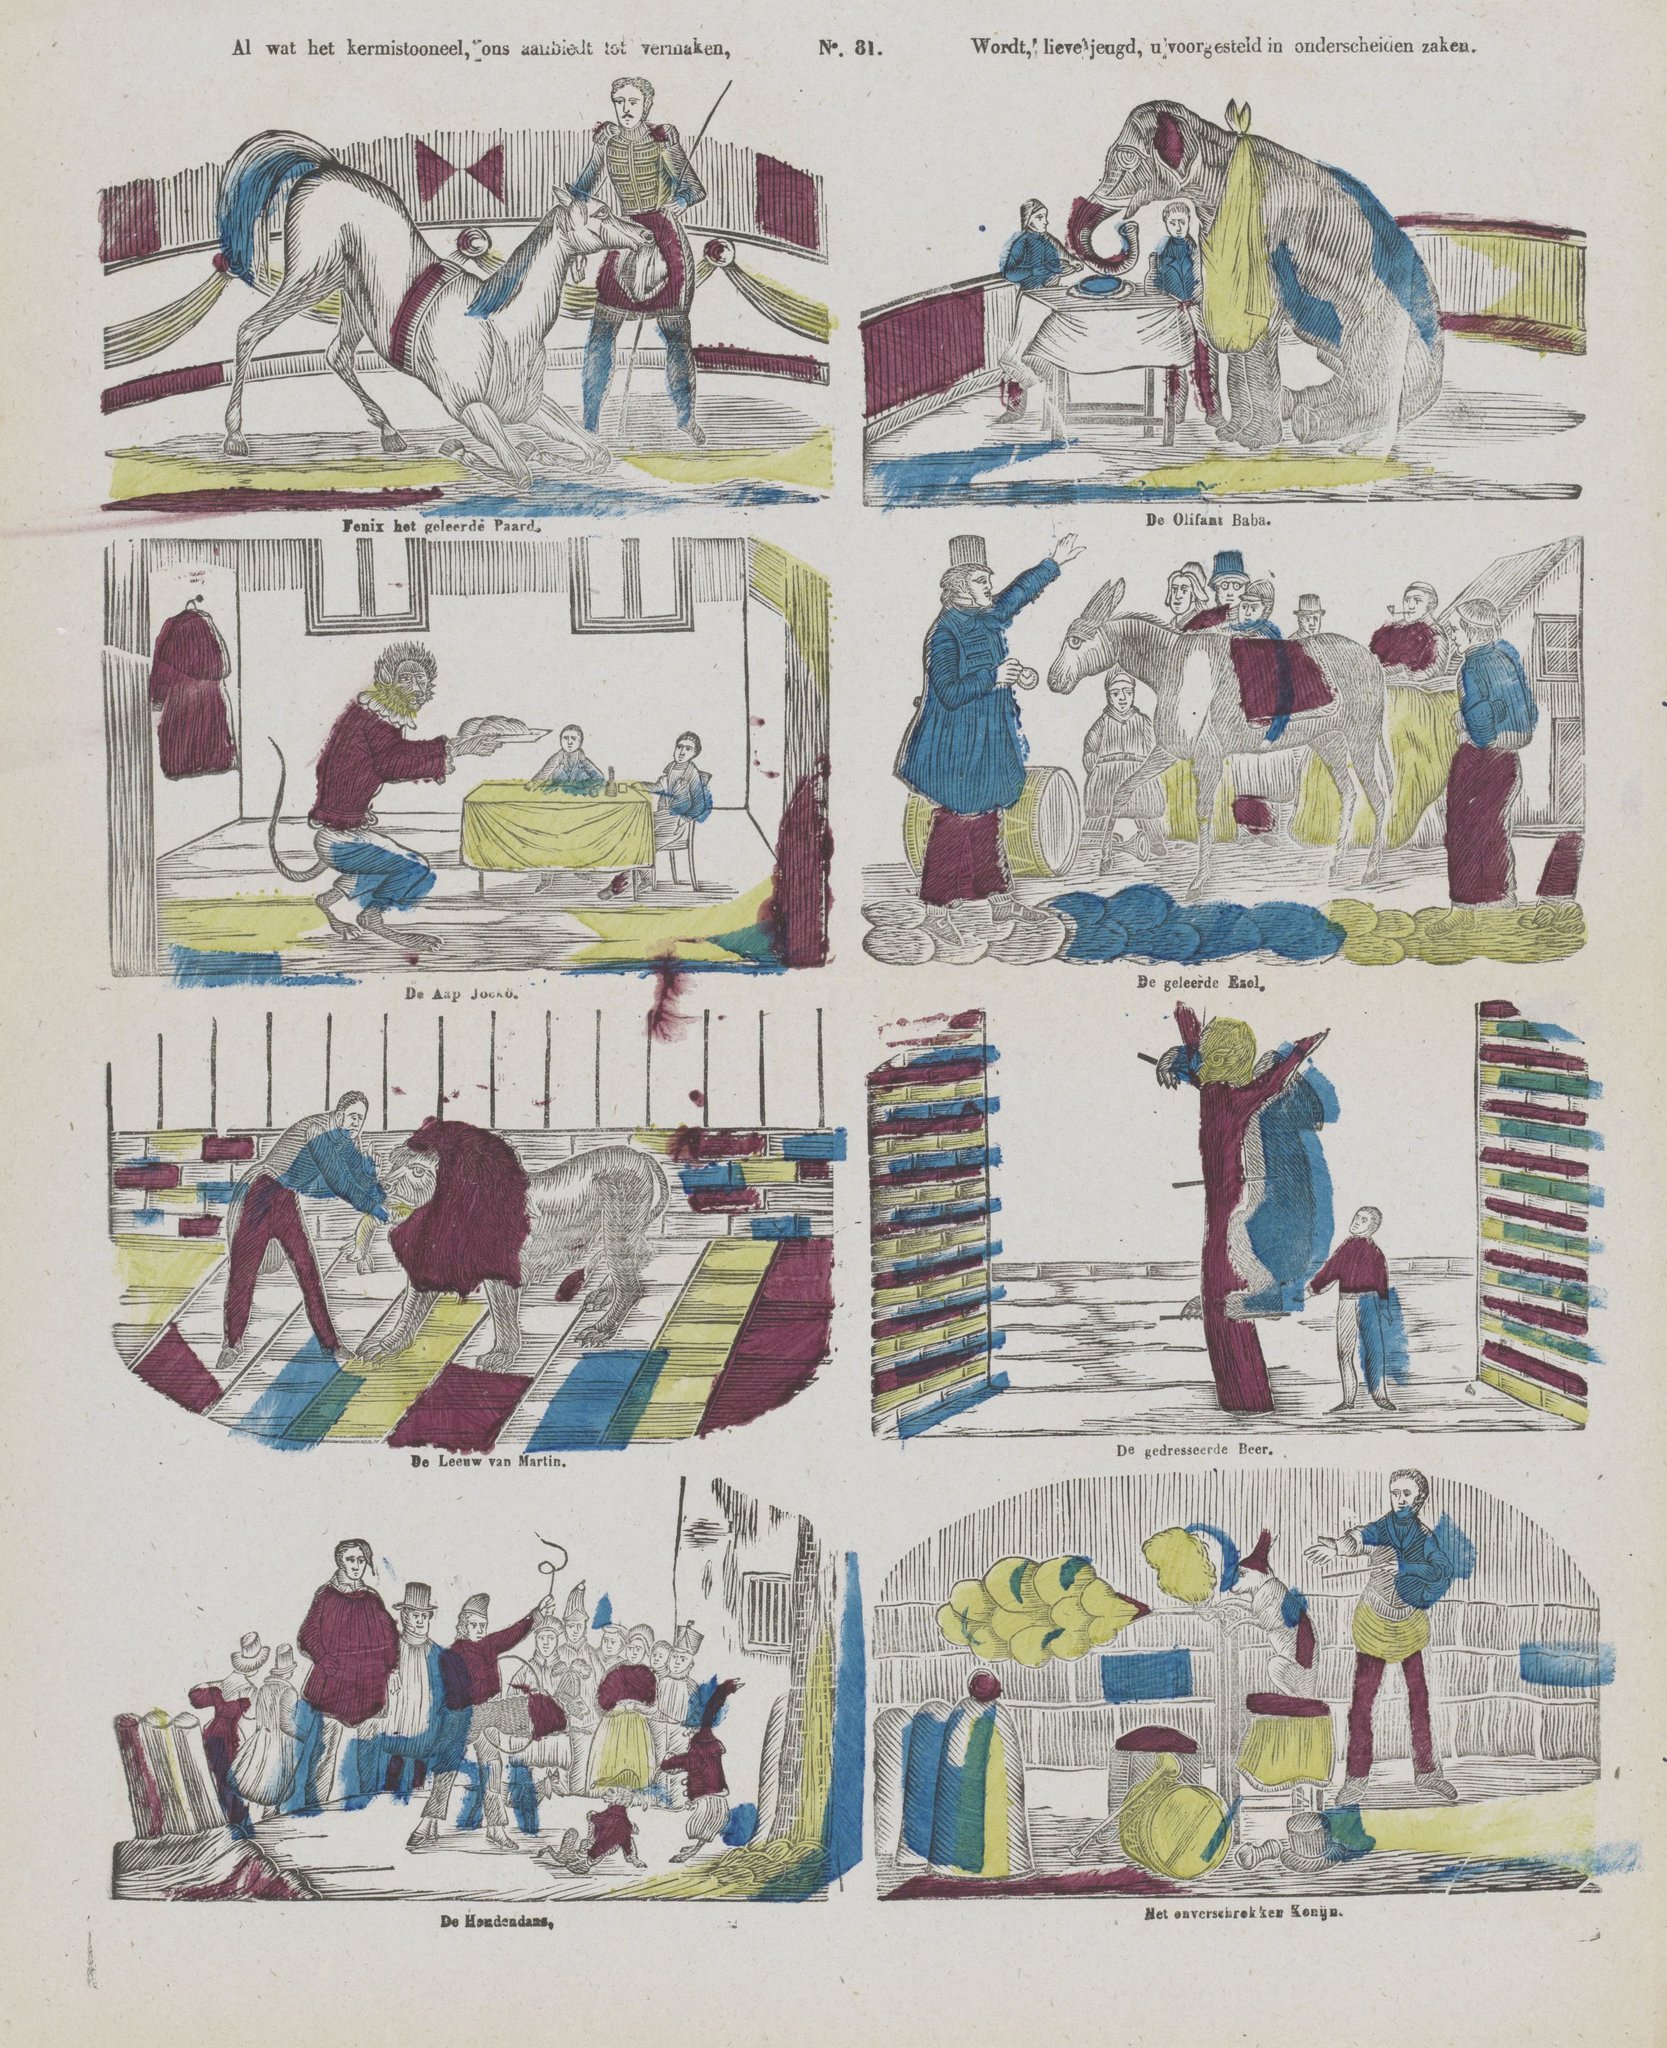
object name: print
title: Al wat het kermistooneel, ons aanbiedt tot vermaken, / Wordt lieve jeugd, u voorgesteld in onderscheiden zaken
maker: Anonymous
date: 1848-1881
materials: paper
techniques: colour, letterpress printing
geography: den bosch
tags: circus animals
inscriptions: collector's mark: Lugt 2760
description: Blad met 8 voorstellingen van circusdieren. Onder elke afbeelding een onderschrift. Genummerd midden boven: No. 81.